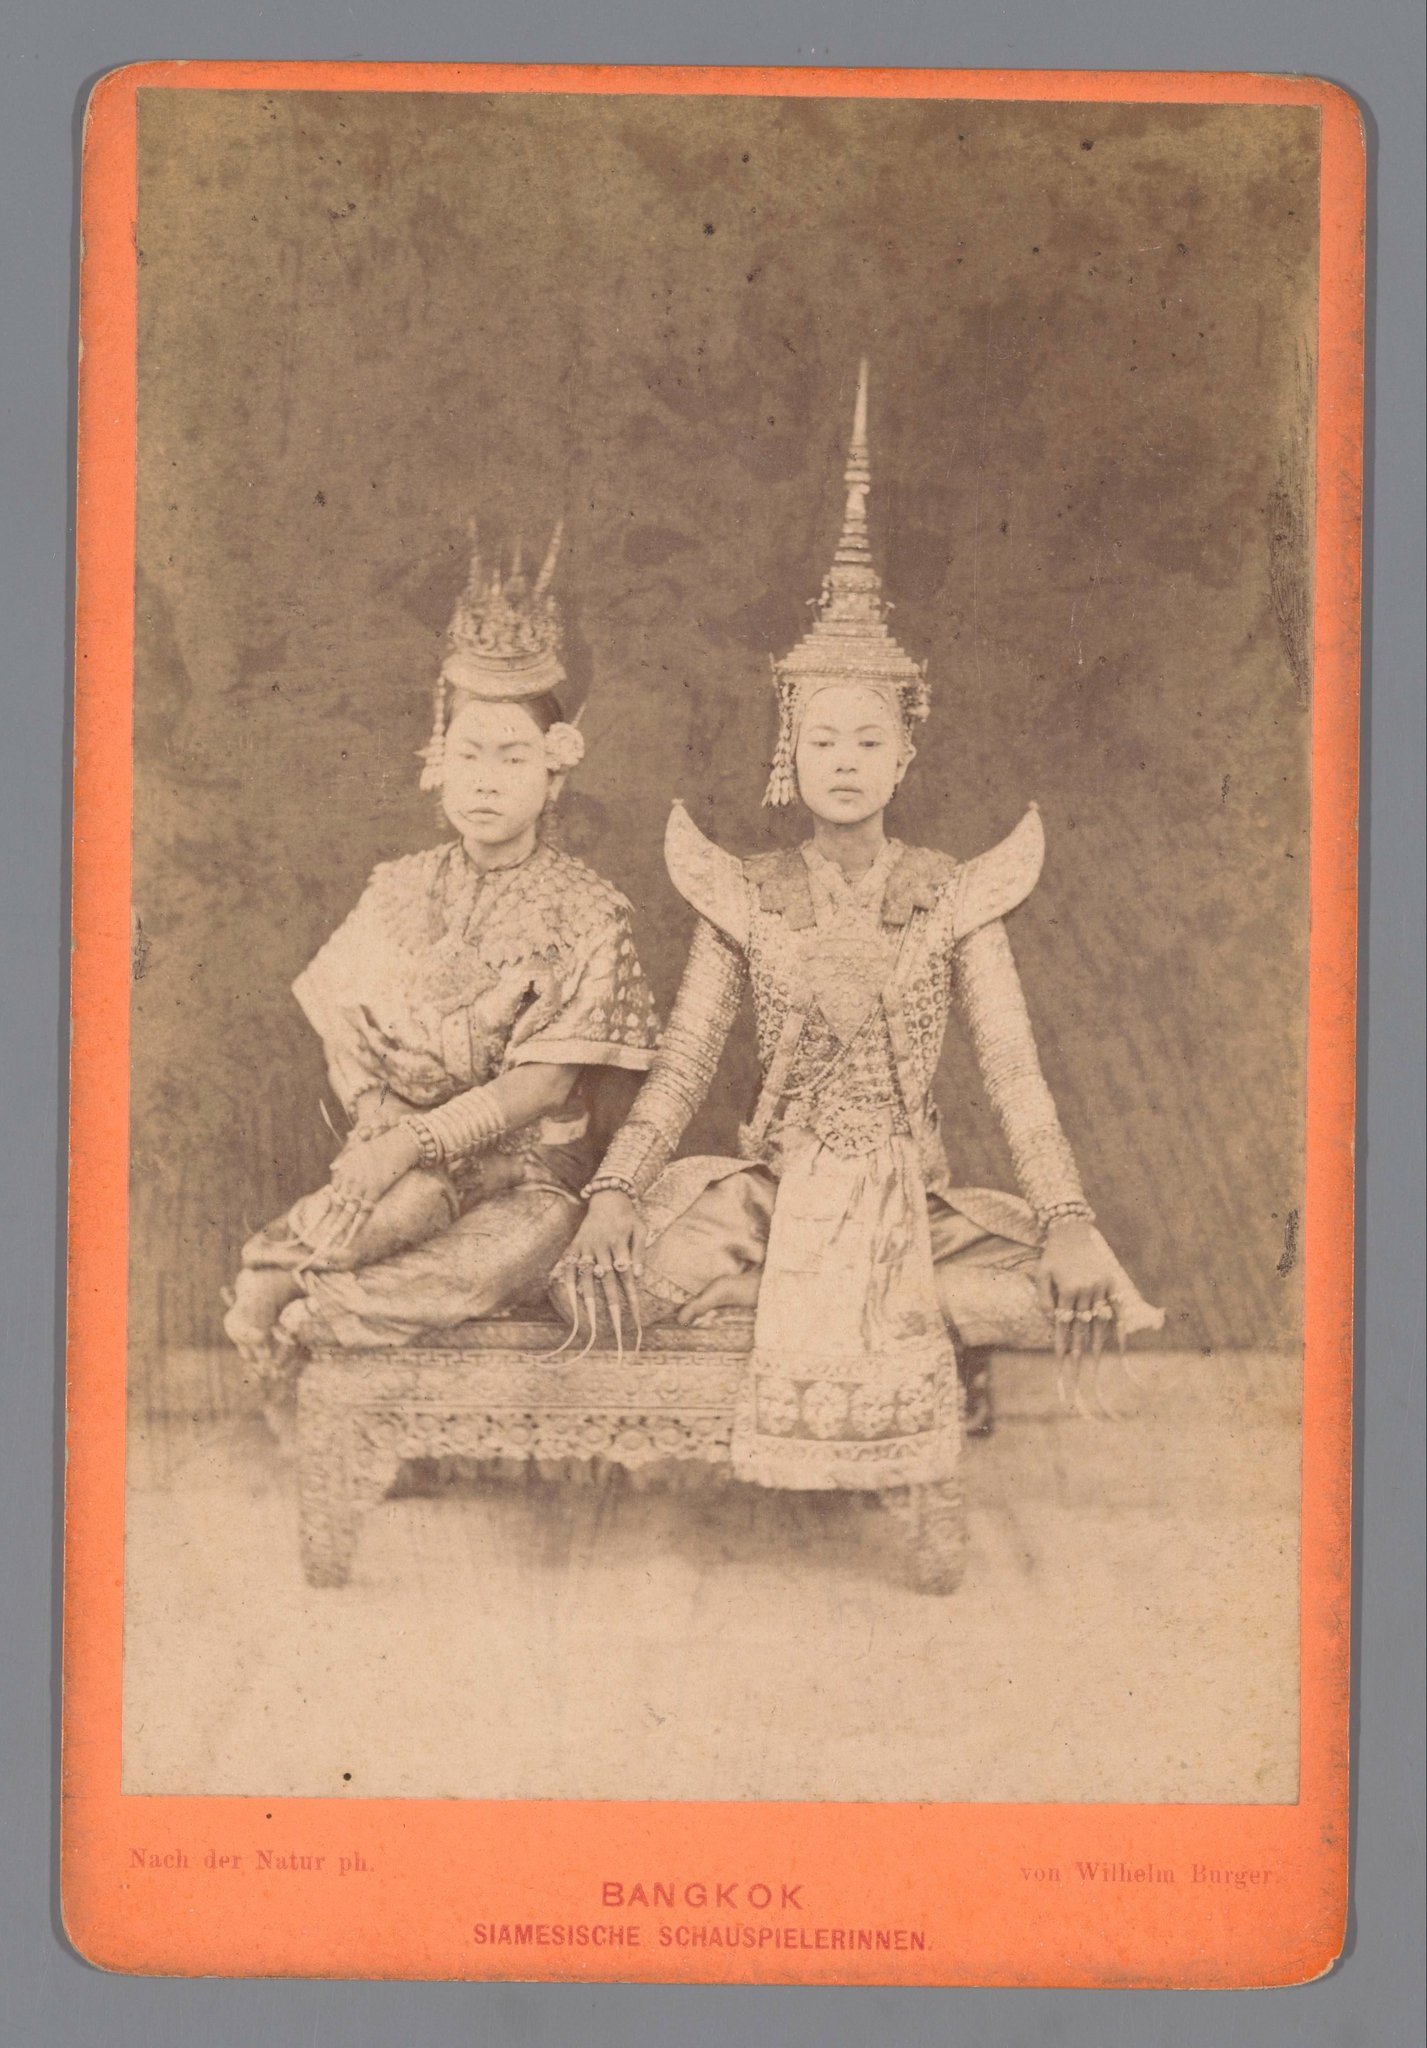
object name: cabinet photograph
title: Bangkok Siamesische Schauspielerinnen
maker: wilhelm burger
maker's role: fotograaf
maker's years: 1844-1920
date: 1860-1890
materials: cardboard, photographic support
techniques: albumen print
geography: bangkok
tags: portrait of actor, actress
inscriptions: name: ‘Wilh. Burger Fotograf der K.K. Ostasiatischen Expedition Jede Art der Vervielfältigung vorbehalten’, number: ‘No. 107.’